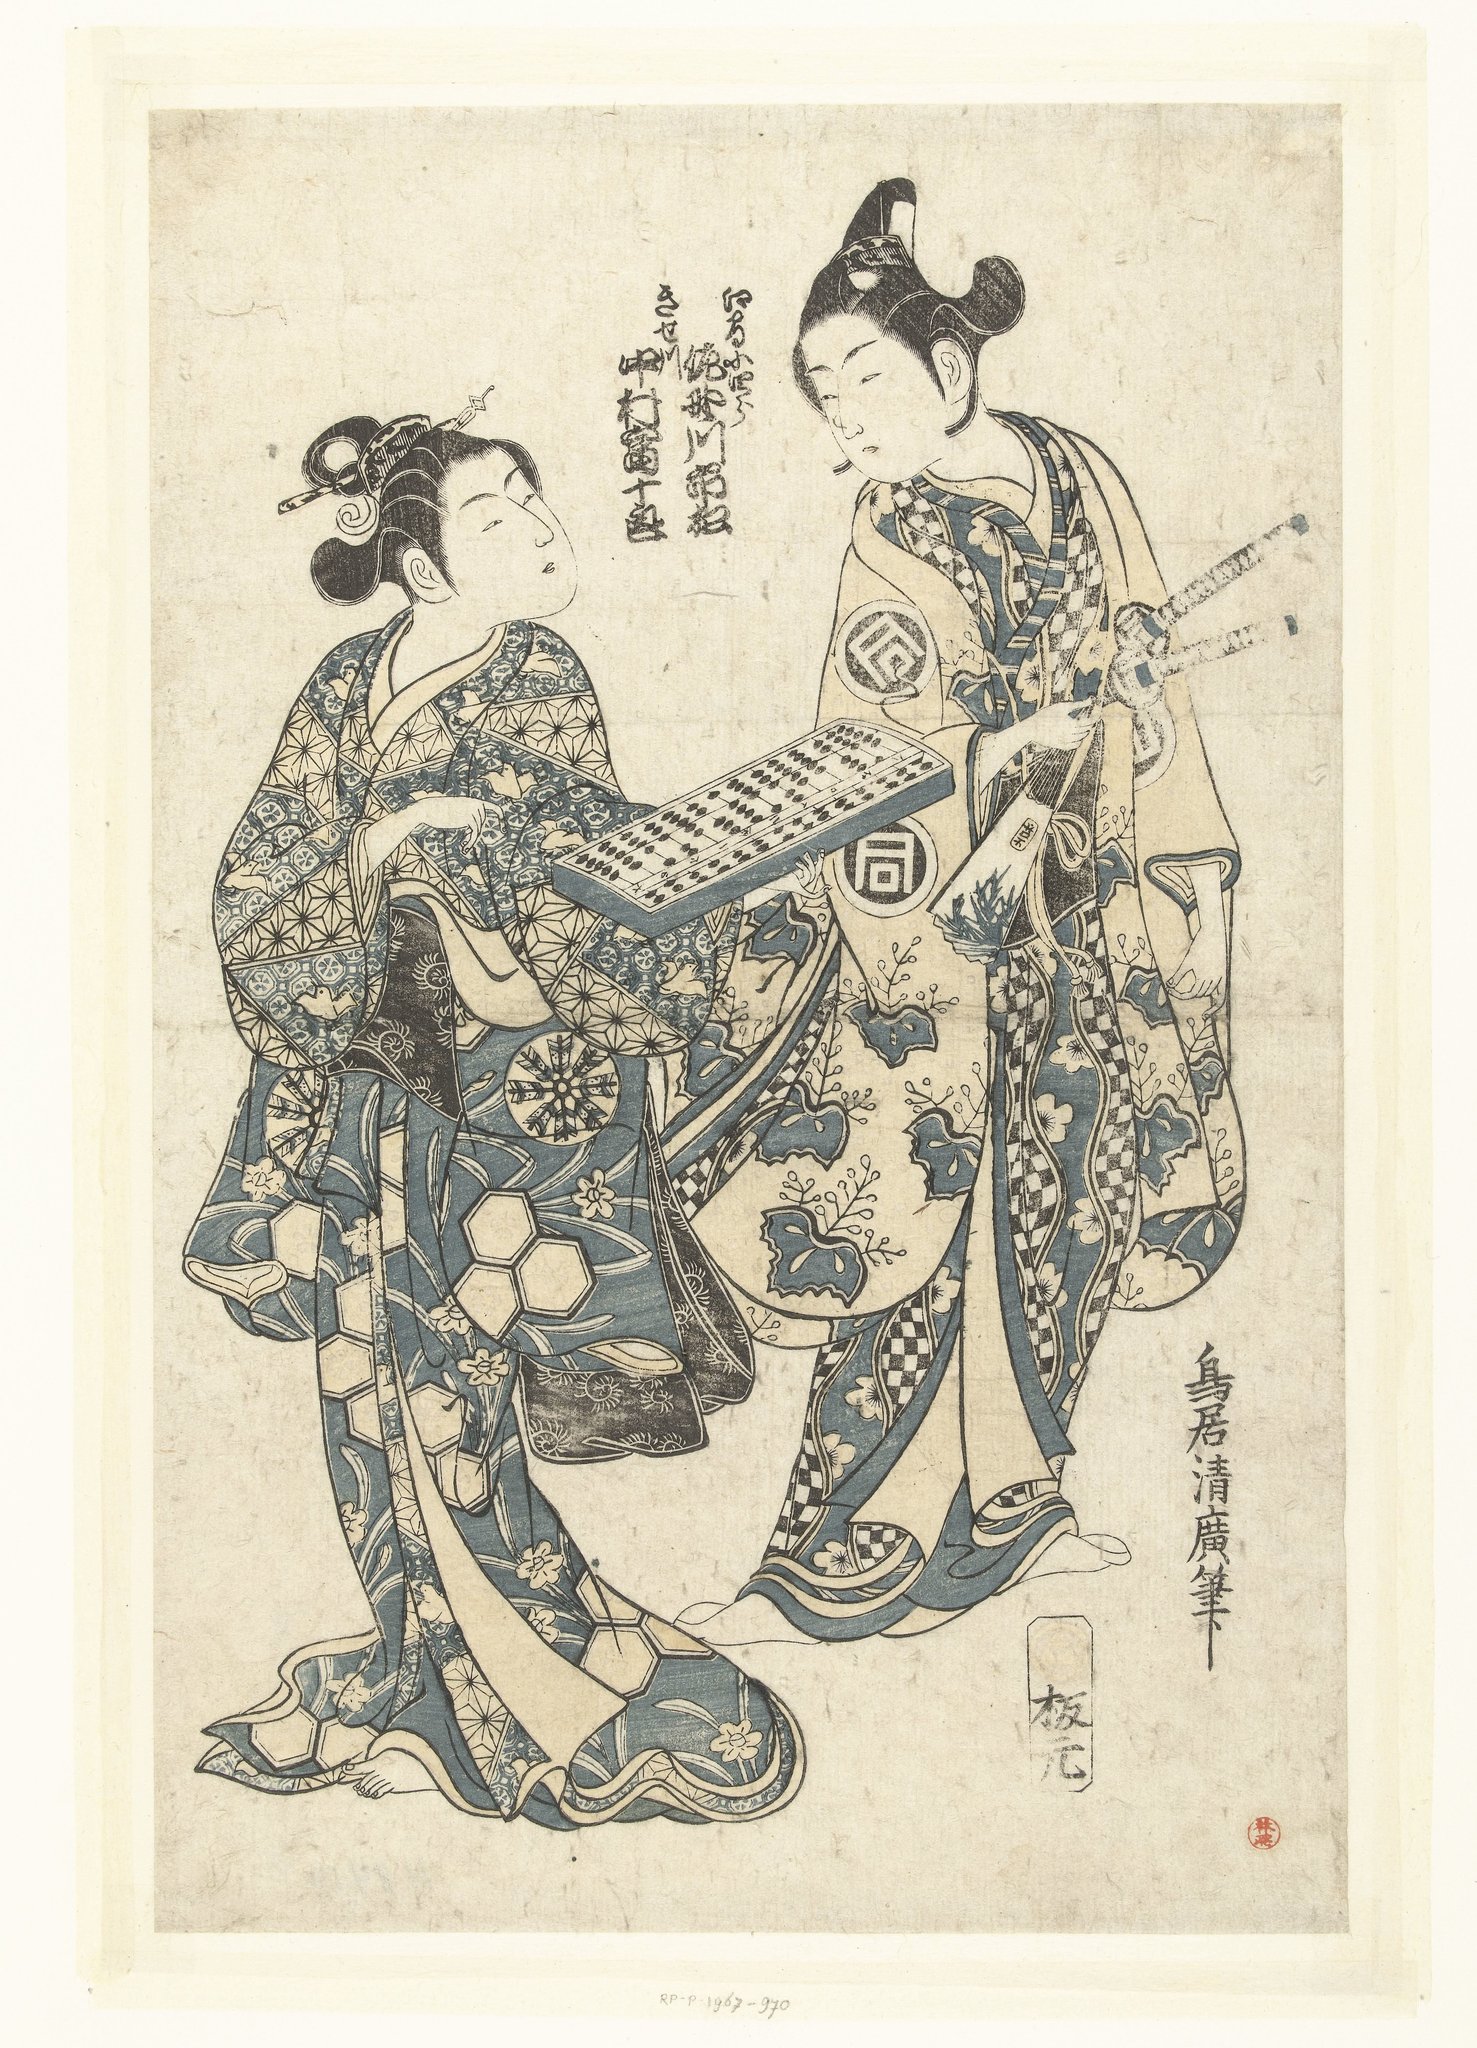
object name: print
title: Twee acteurs met telraam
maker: torii kiyohiro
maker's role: print maker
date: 1752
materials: paper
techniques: woodcut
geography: tokyo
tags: abacus, counting-frame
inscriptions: collector's mark: Lugt 2971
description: Nakamura Tomijuro in de rol van de courtisane Kisegawa, met telraam in linker hand, staand naast Sanokawa Ichimatsu in de rol van Ema Koshiro, met twee zwaarden en een waaier.